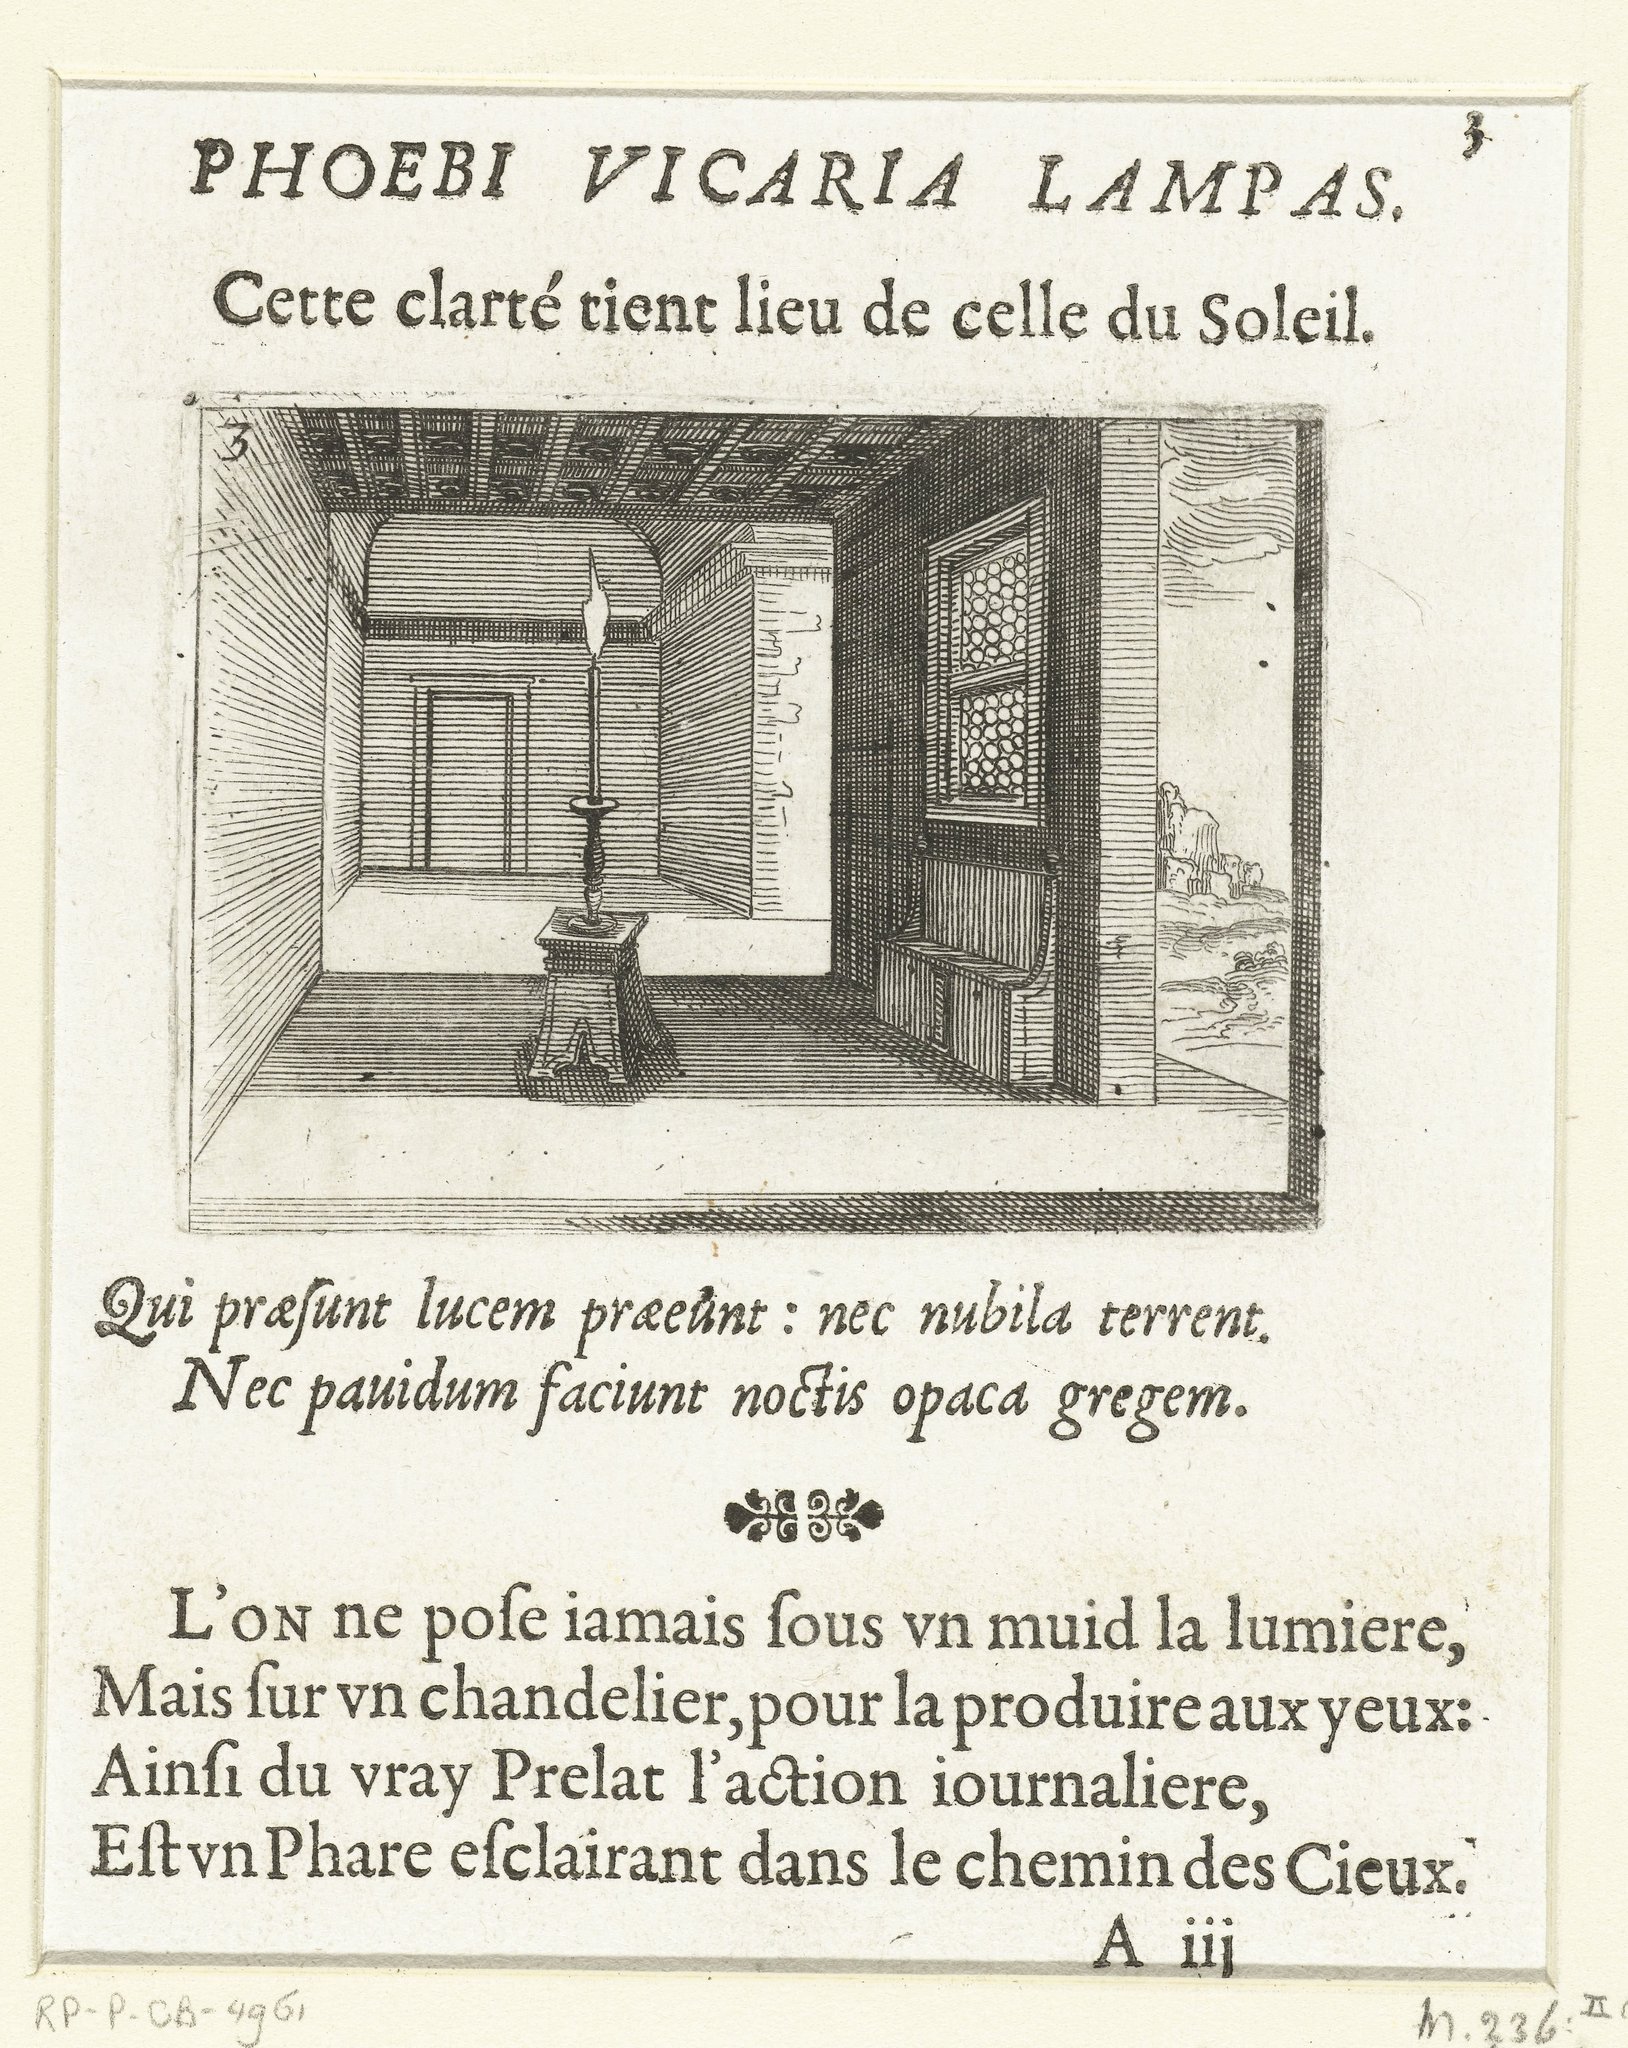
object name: cognizance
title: Kloosterleven in emblemen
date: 1621-1635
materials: paper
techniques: etching, letterpress printing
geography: paris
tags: candle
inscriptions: collector's mark: Lugt 240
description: Voorstelling van een brandende kaars op een kruk in een leeg vertrek. Boven en onder deze prent Latijnse en Franse teksten in boekdruk. Dit blad is onderdeel van de embleemserie 'Kloosterleven in emblemen'. De tweede staat van deze serie behelst naast een geïllustreerde titelpagina en 26 emblemen nog een titelpagina en een blad met opdracht, beide in boekdruk zonder afbeelding.